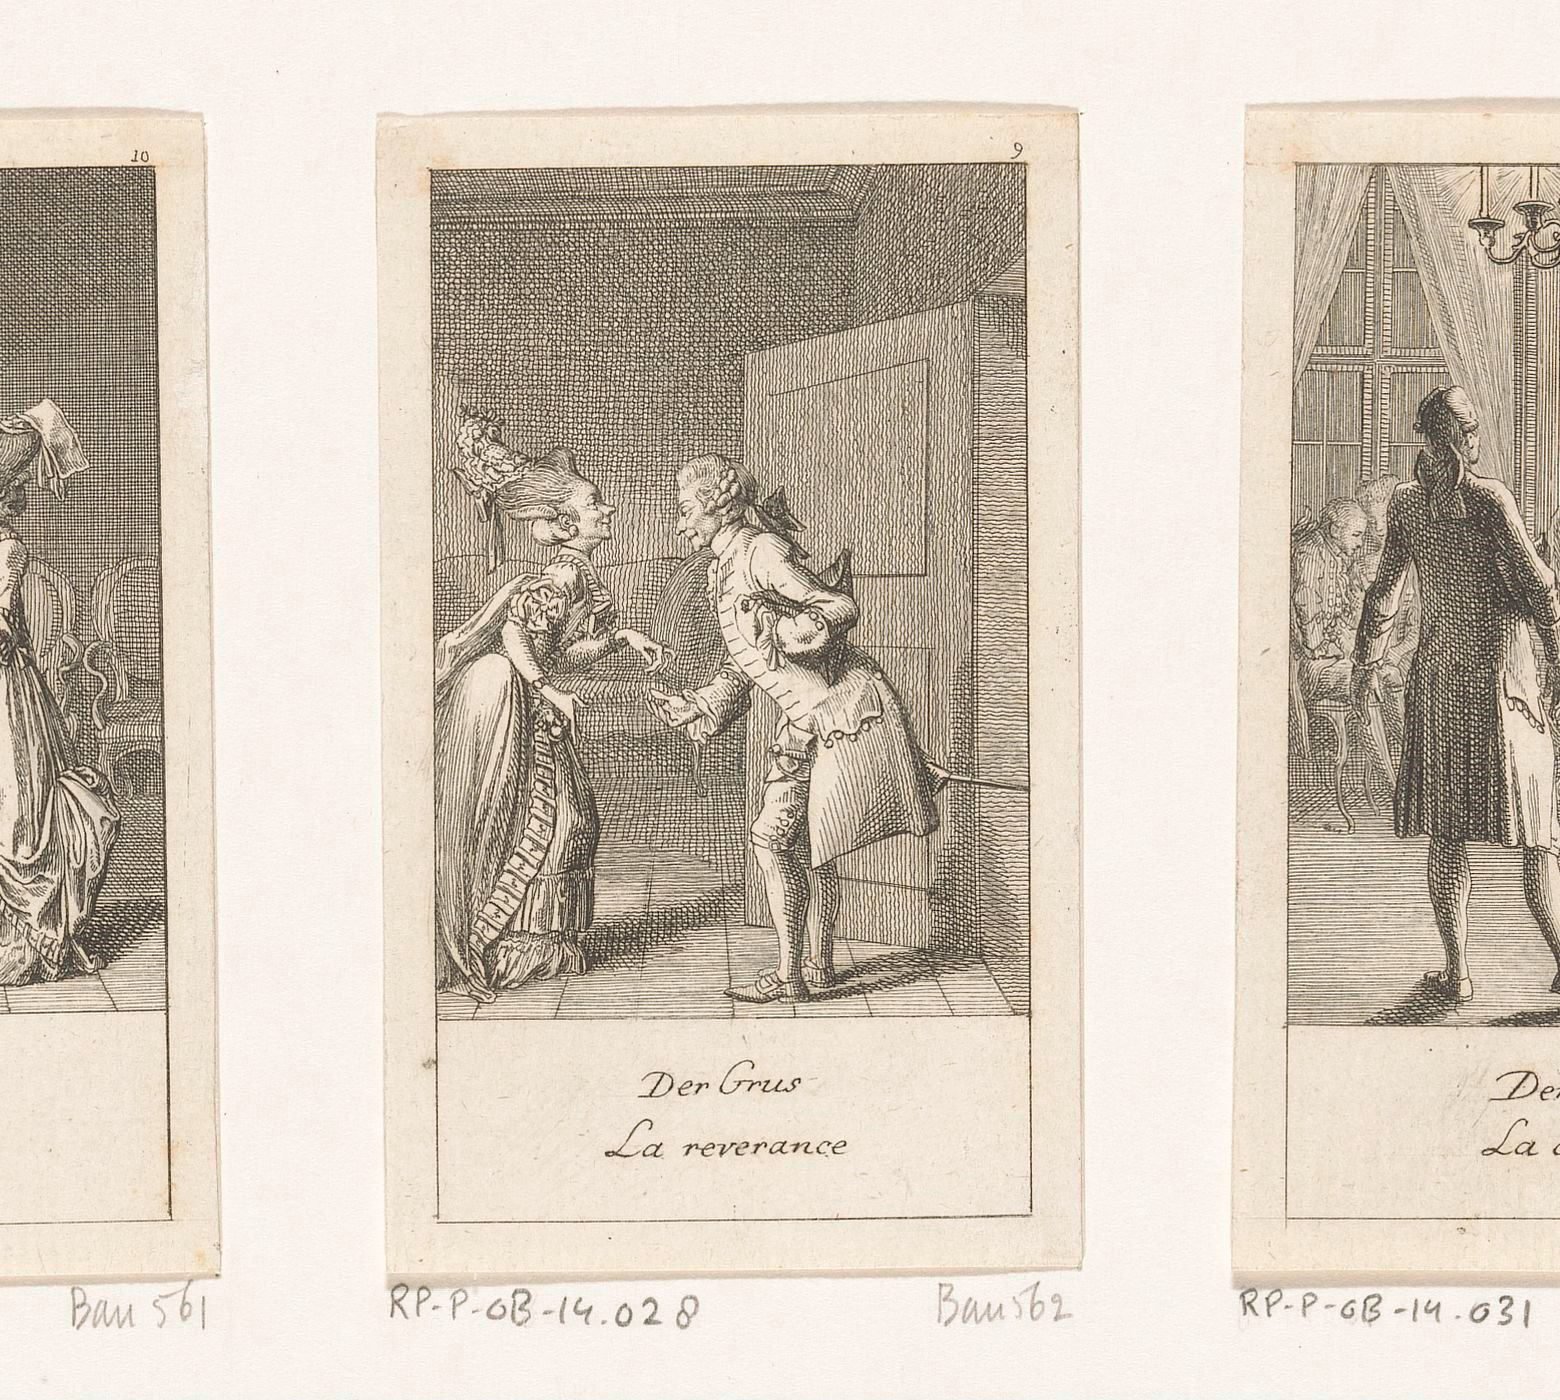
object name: print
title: Der Grus / La reverance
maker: daniel nikolaus chodowiecki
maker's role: draughtsman, print maker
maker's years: 1726-1801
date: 1778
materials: paper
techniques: etching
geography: berlin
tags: physicist, head bent forward; bowing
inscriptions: collector's mark: Lugt 2228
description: Negende prent uit een serie van twaalf taferelen die 'Natürliche und affectirte Handlungen des Lebens' (eerste serie) illustreren waarin 'natuurlijk' en 'geaffecteerd' gedrag op karikaturale wijze tegenover elkaar worden gezet. Deze taferelen zijn op een plaat geëtst. Deze serie, voorzien van toelichtingen door Georg Christoph Lichtenberg, is ook gebruikt in: Goettinger Taschen Calender vom Jahre 1779. Göttingen: Johann Christian Dieterich.